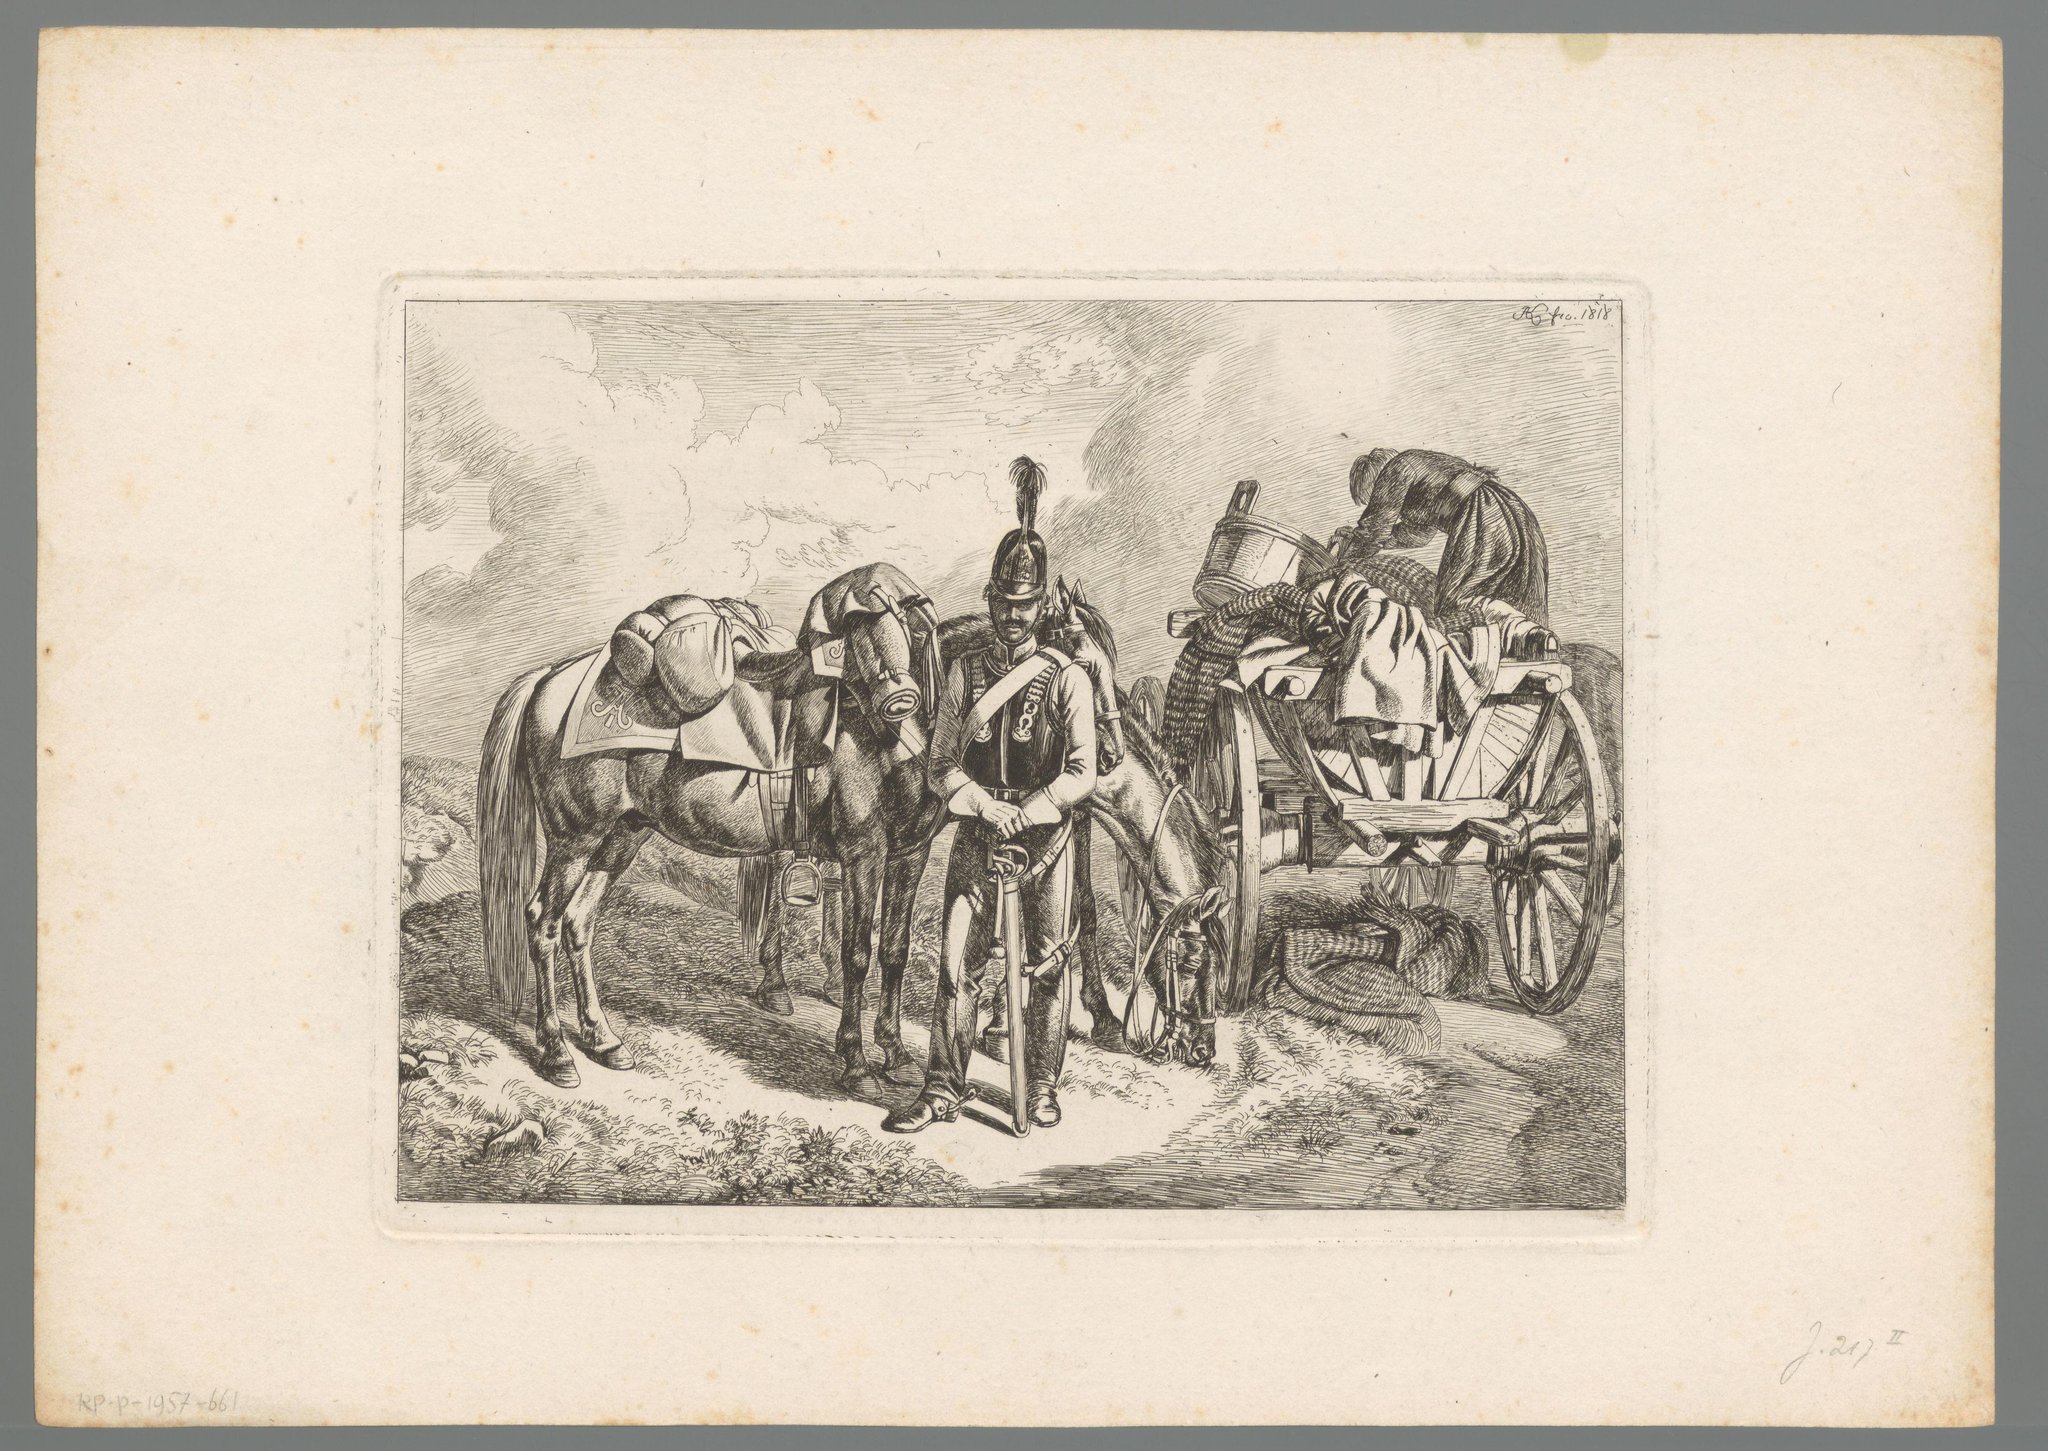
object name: print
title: Kurassier bij twee paarden en een trekkar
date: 1818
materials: paper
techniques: etching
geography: mannheim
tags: (traveller) resting in the open air, horse, two-wheeled vehicle drawn by two animals, (farm) wagon, freight wagon, cart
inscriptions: collector's mark: Lugt 2228, collector's mark: Lugt 2760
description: Deze prent maakt deel uit van een omslag met zes prenten.